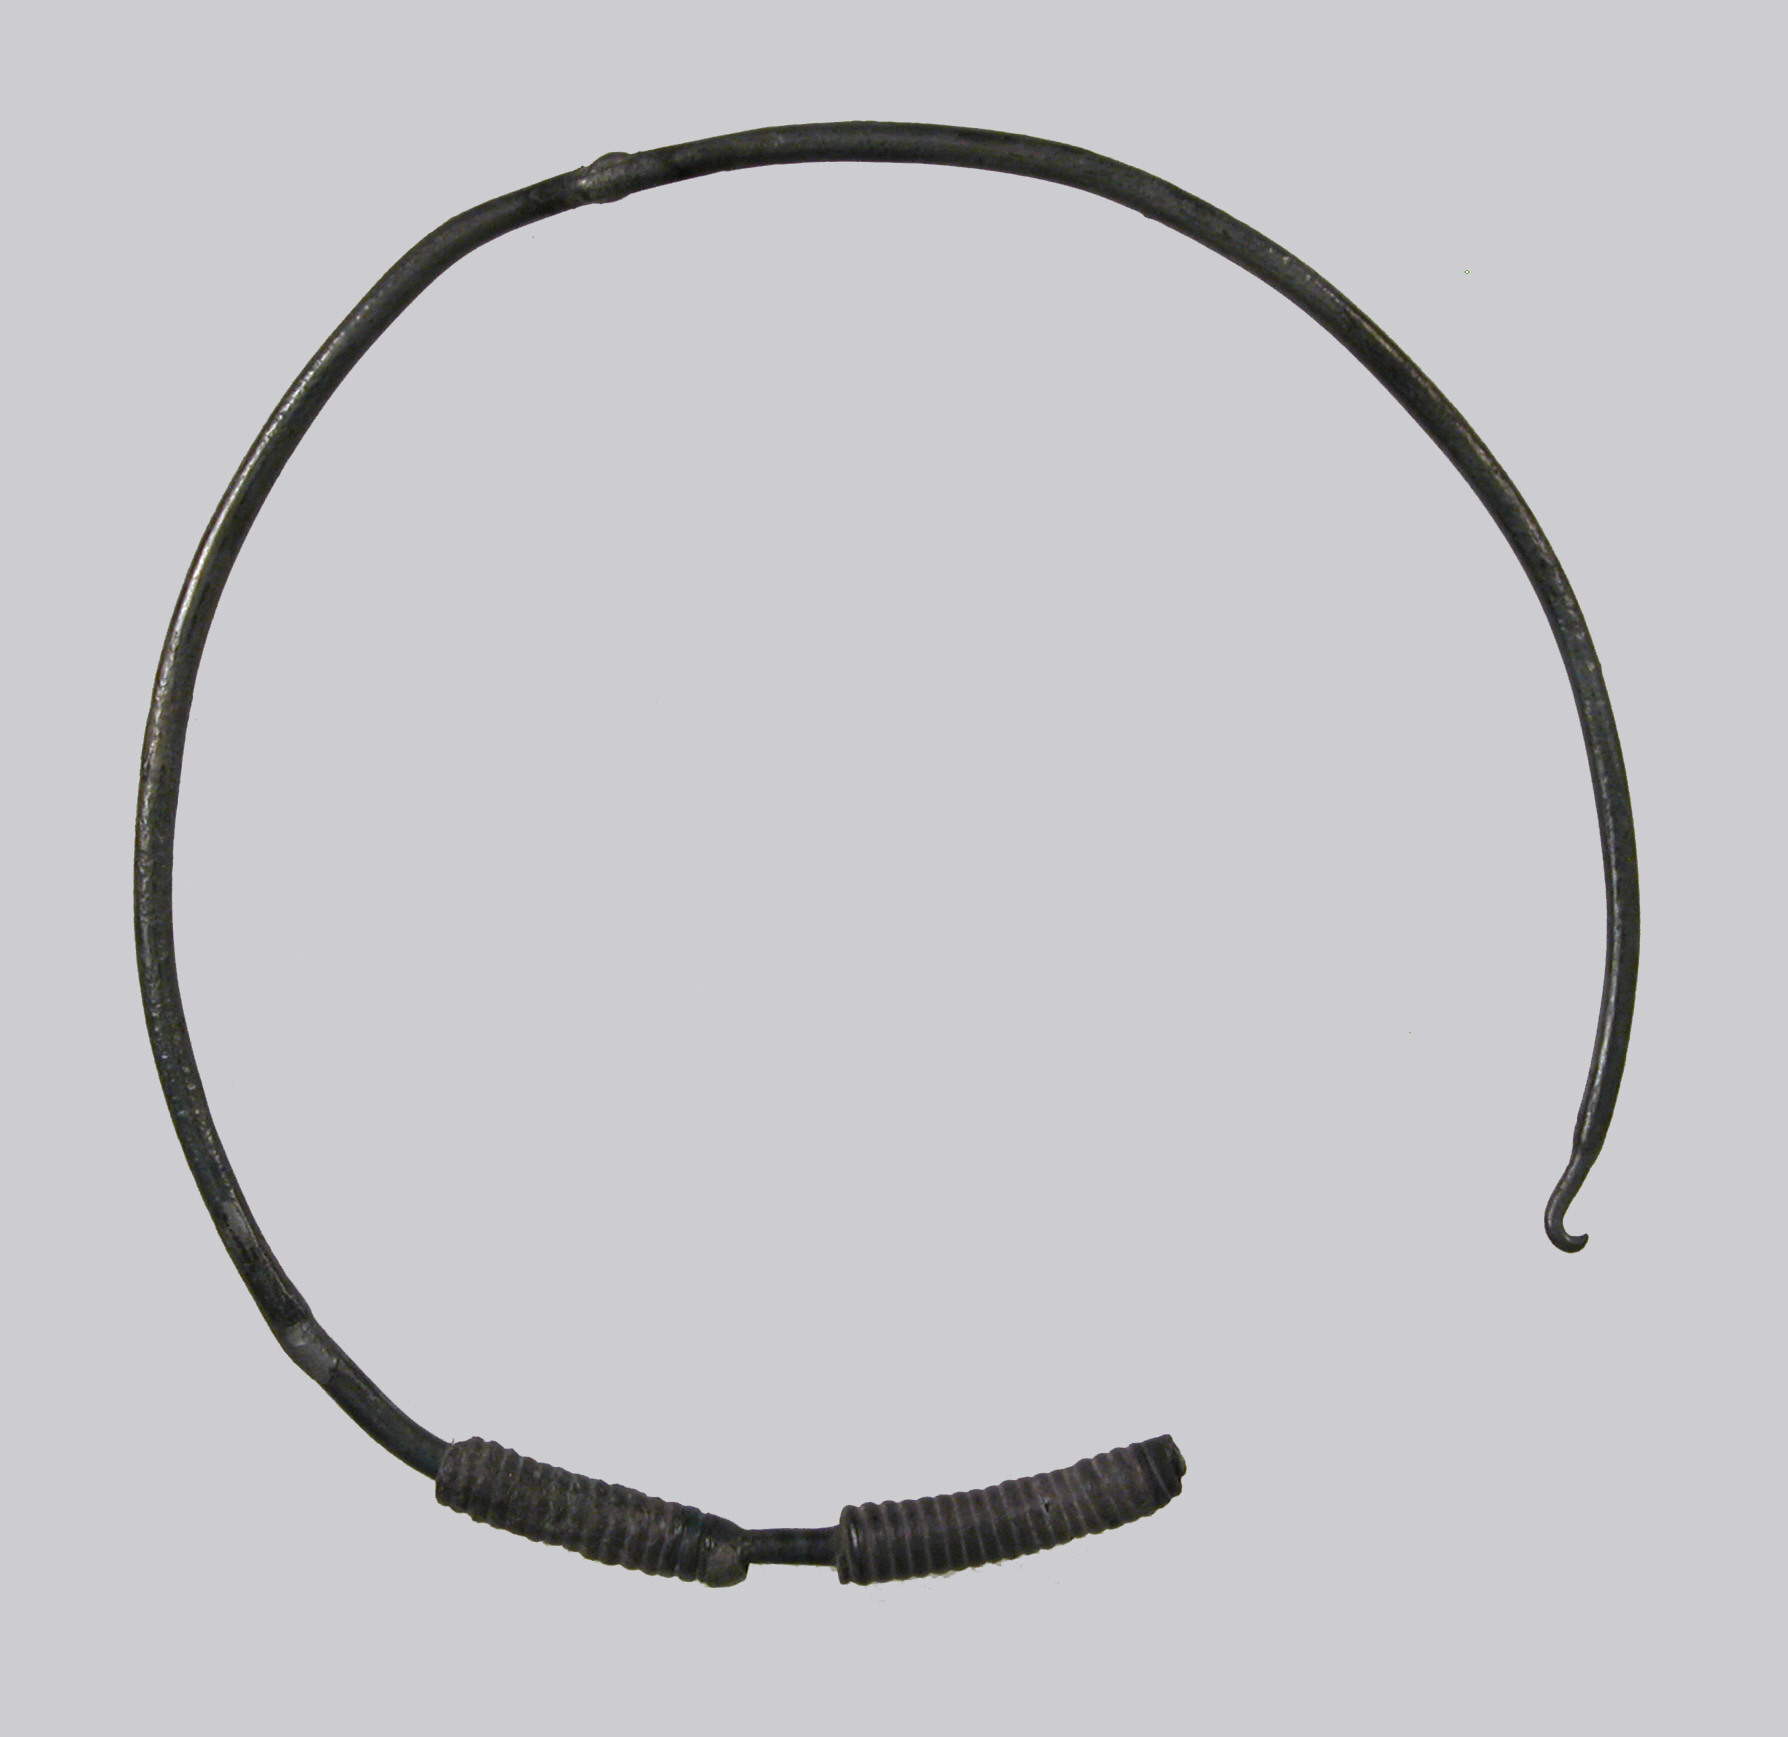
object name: earring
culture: frankish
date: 601-700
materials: silver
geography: germany